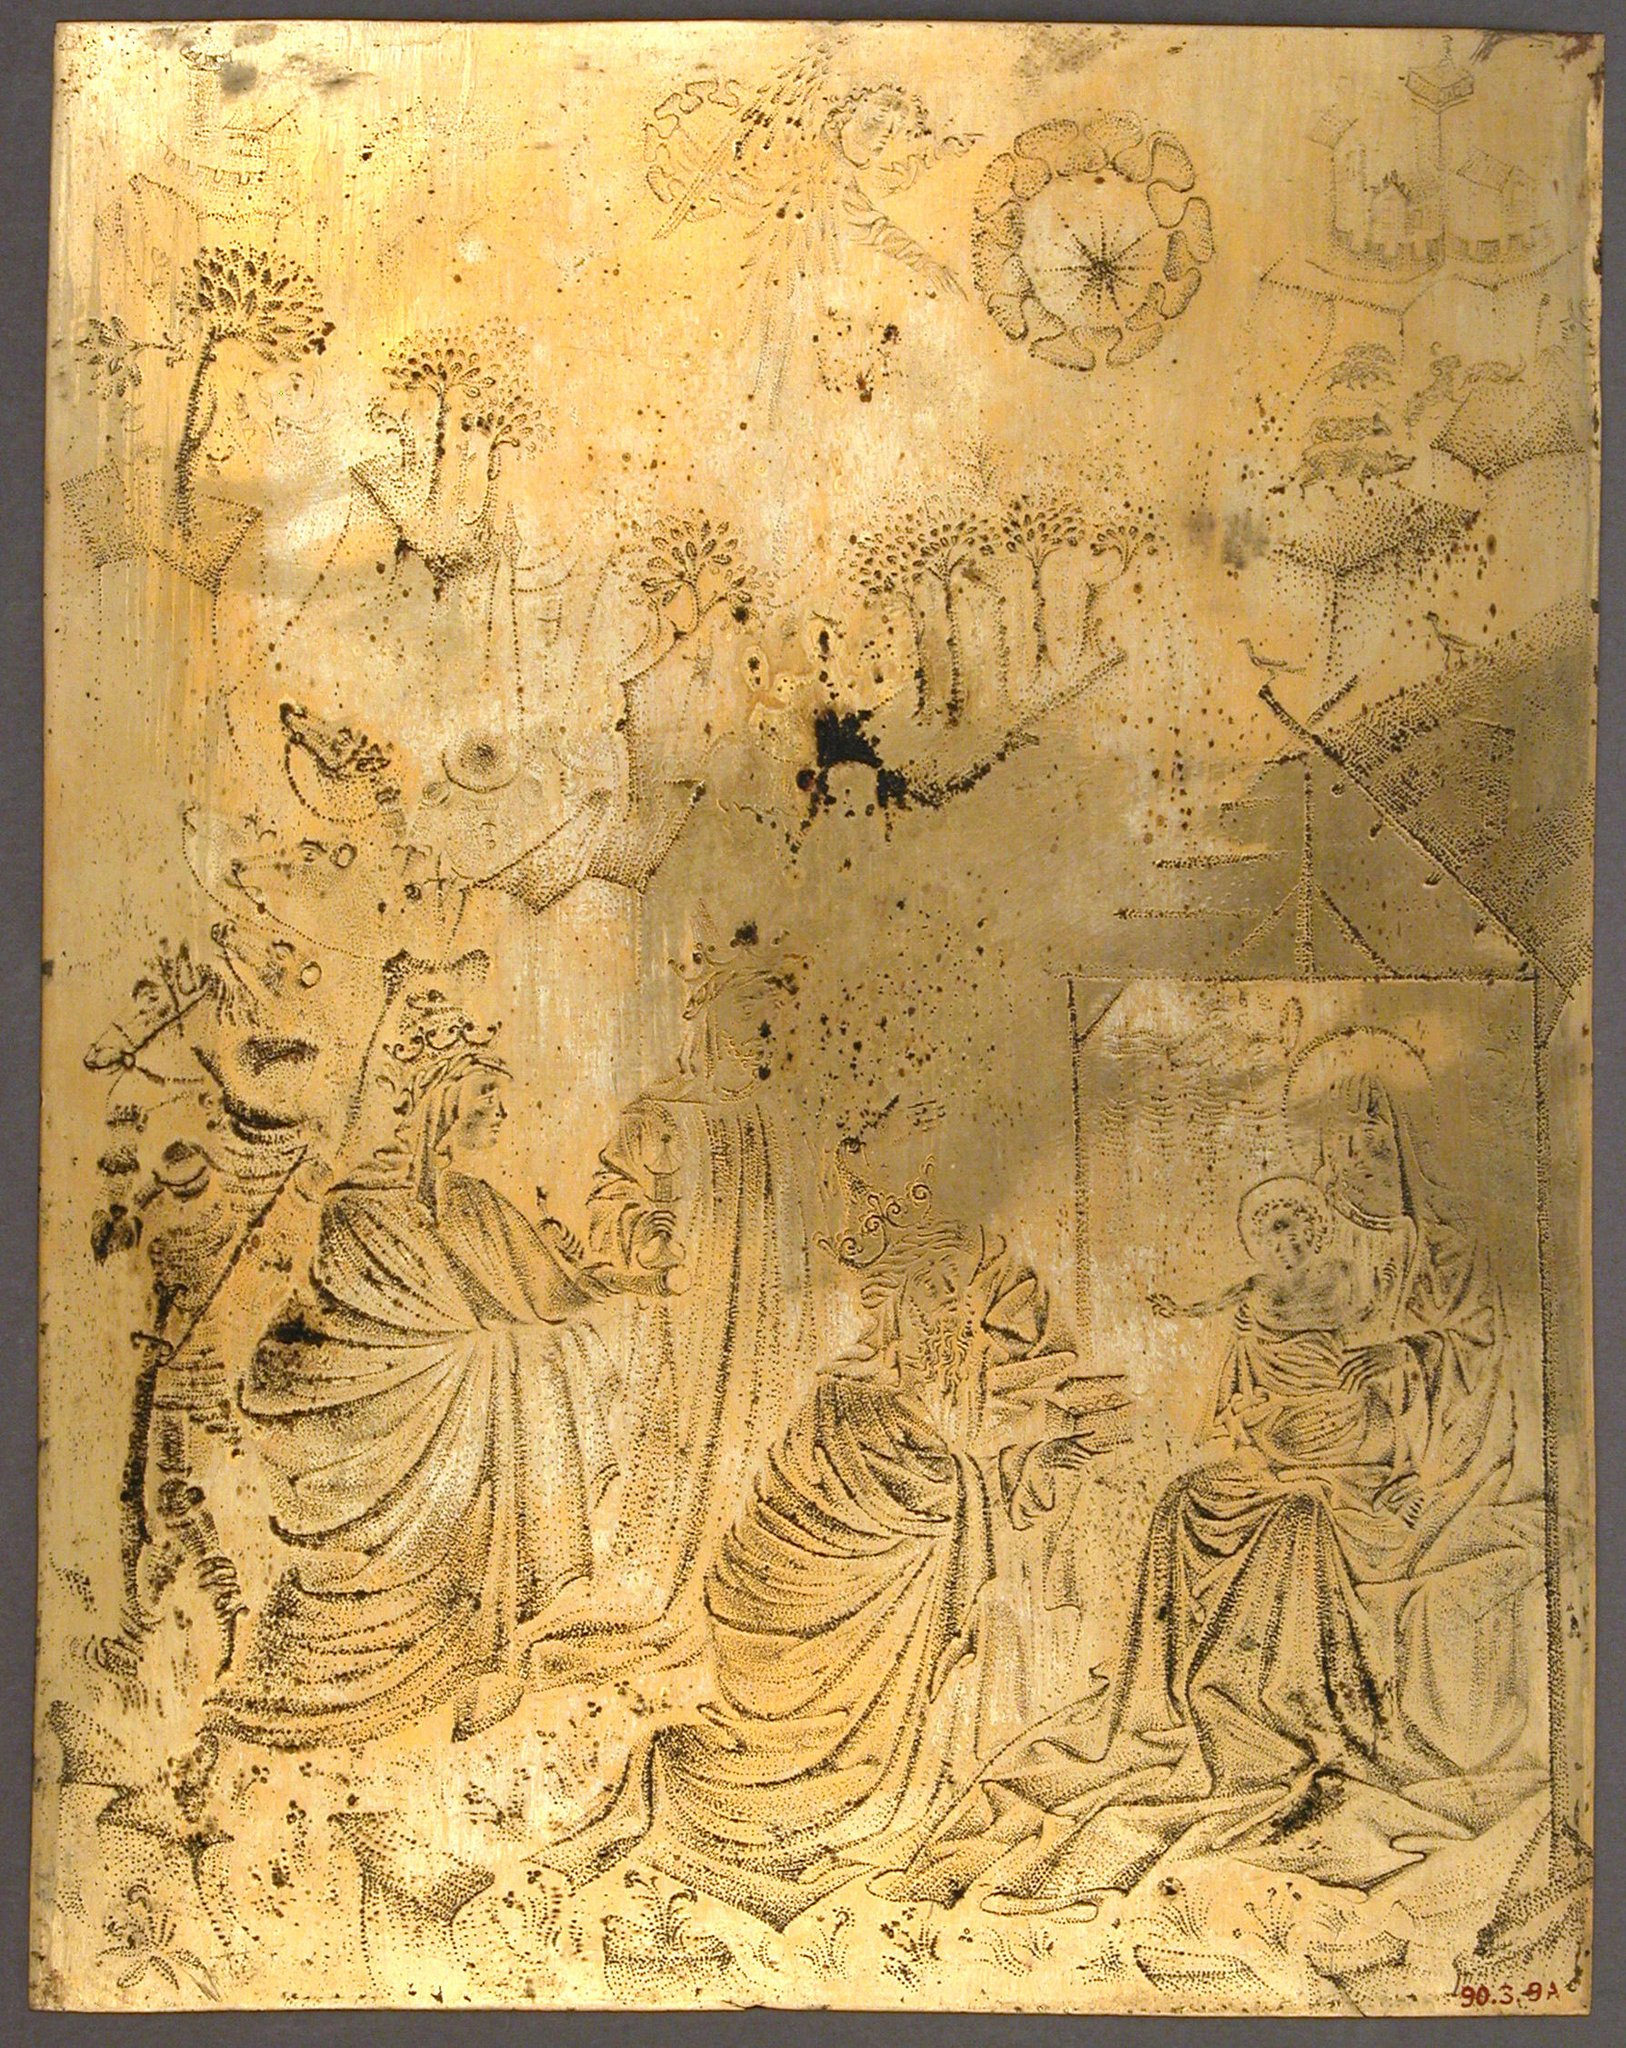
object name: triptych panel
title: Plaque from Triptych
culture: german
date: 1434-1466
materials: gilt copper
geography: germany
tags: angels